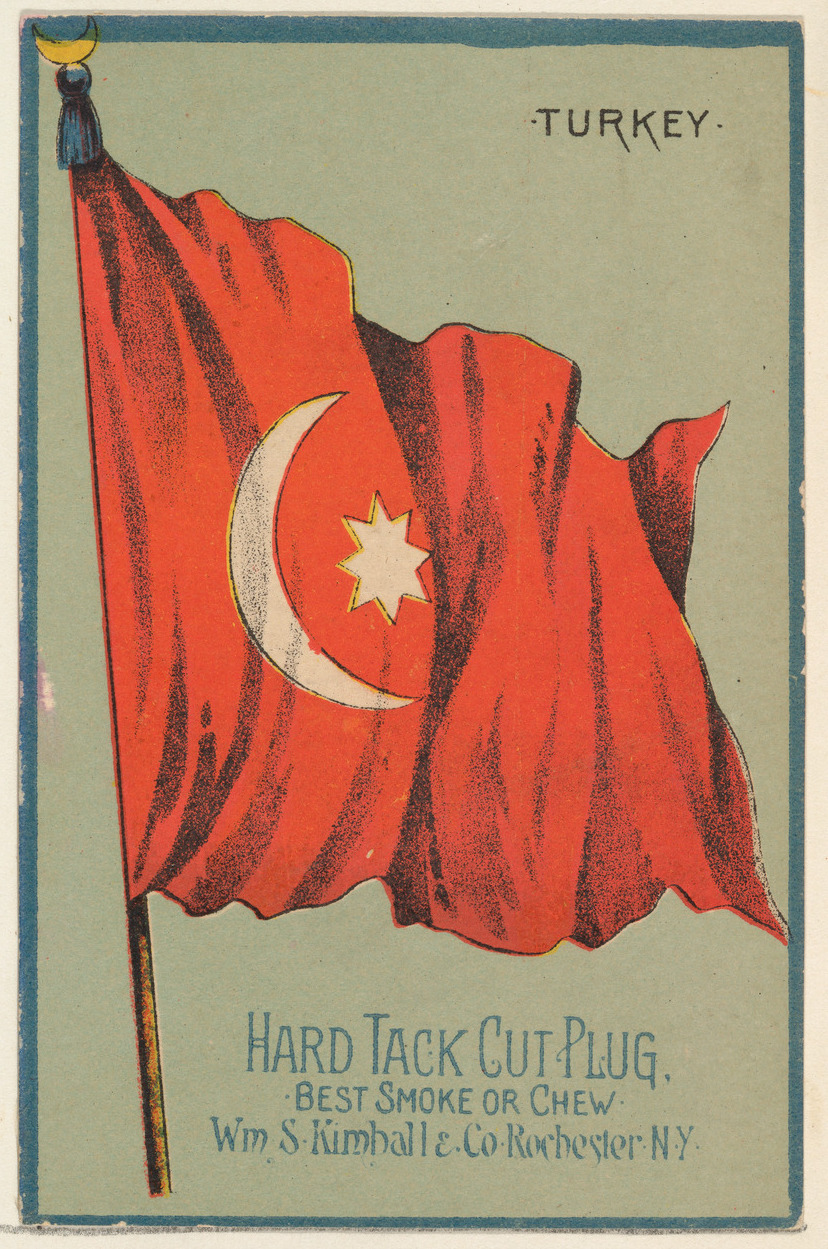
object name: print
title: Turkey, from the National Flags series (N195) issued by Wm. S. Kimball & Co.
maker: william s. kimball & company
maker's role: publisher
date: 1891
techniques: color lithograph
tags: flags